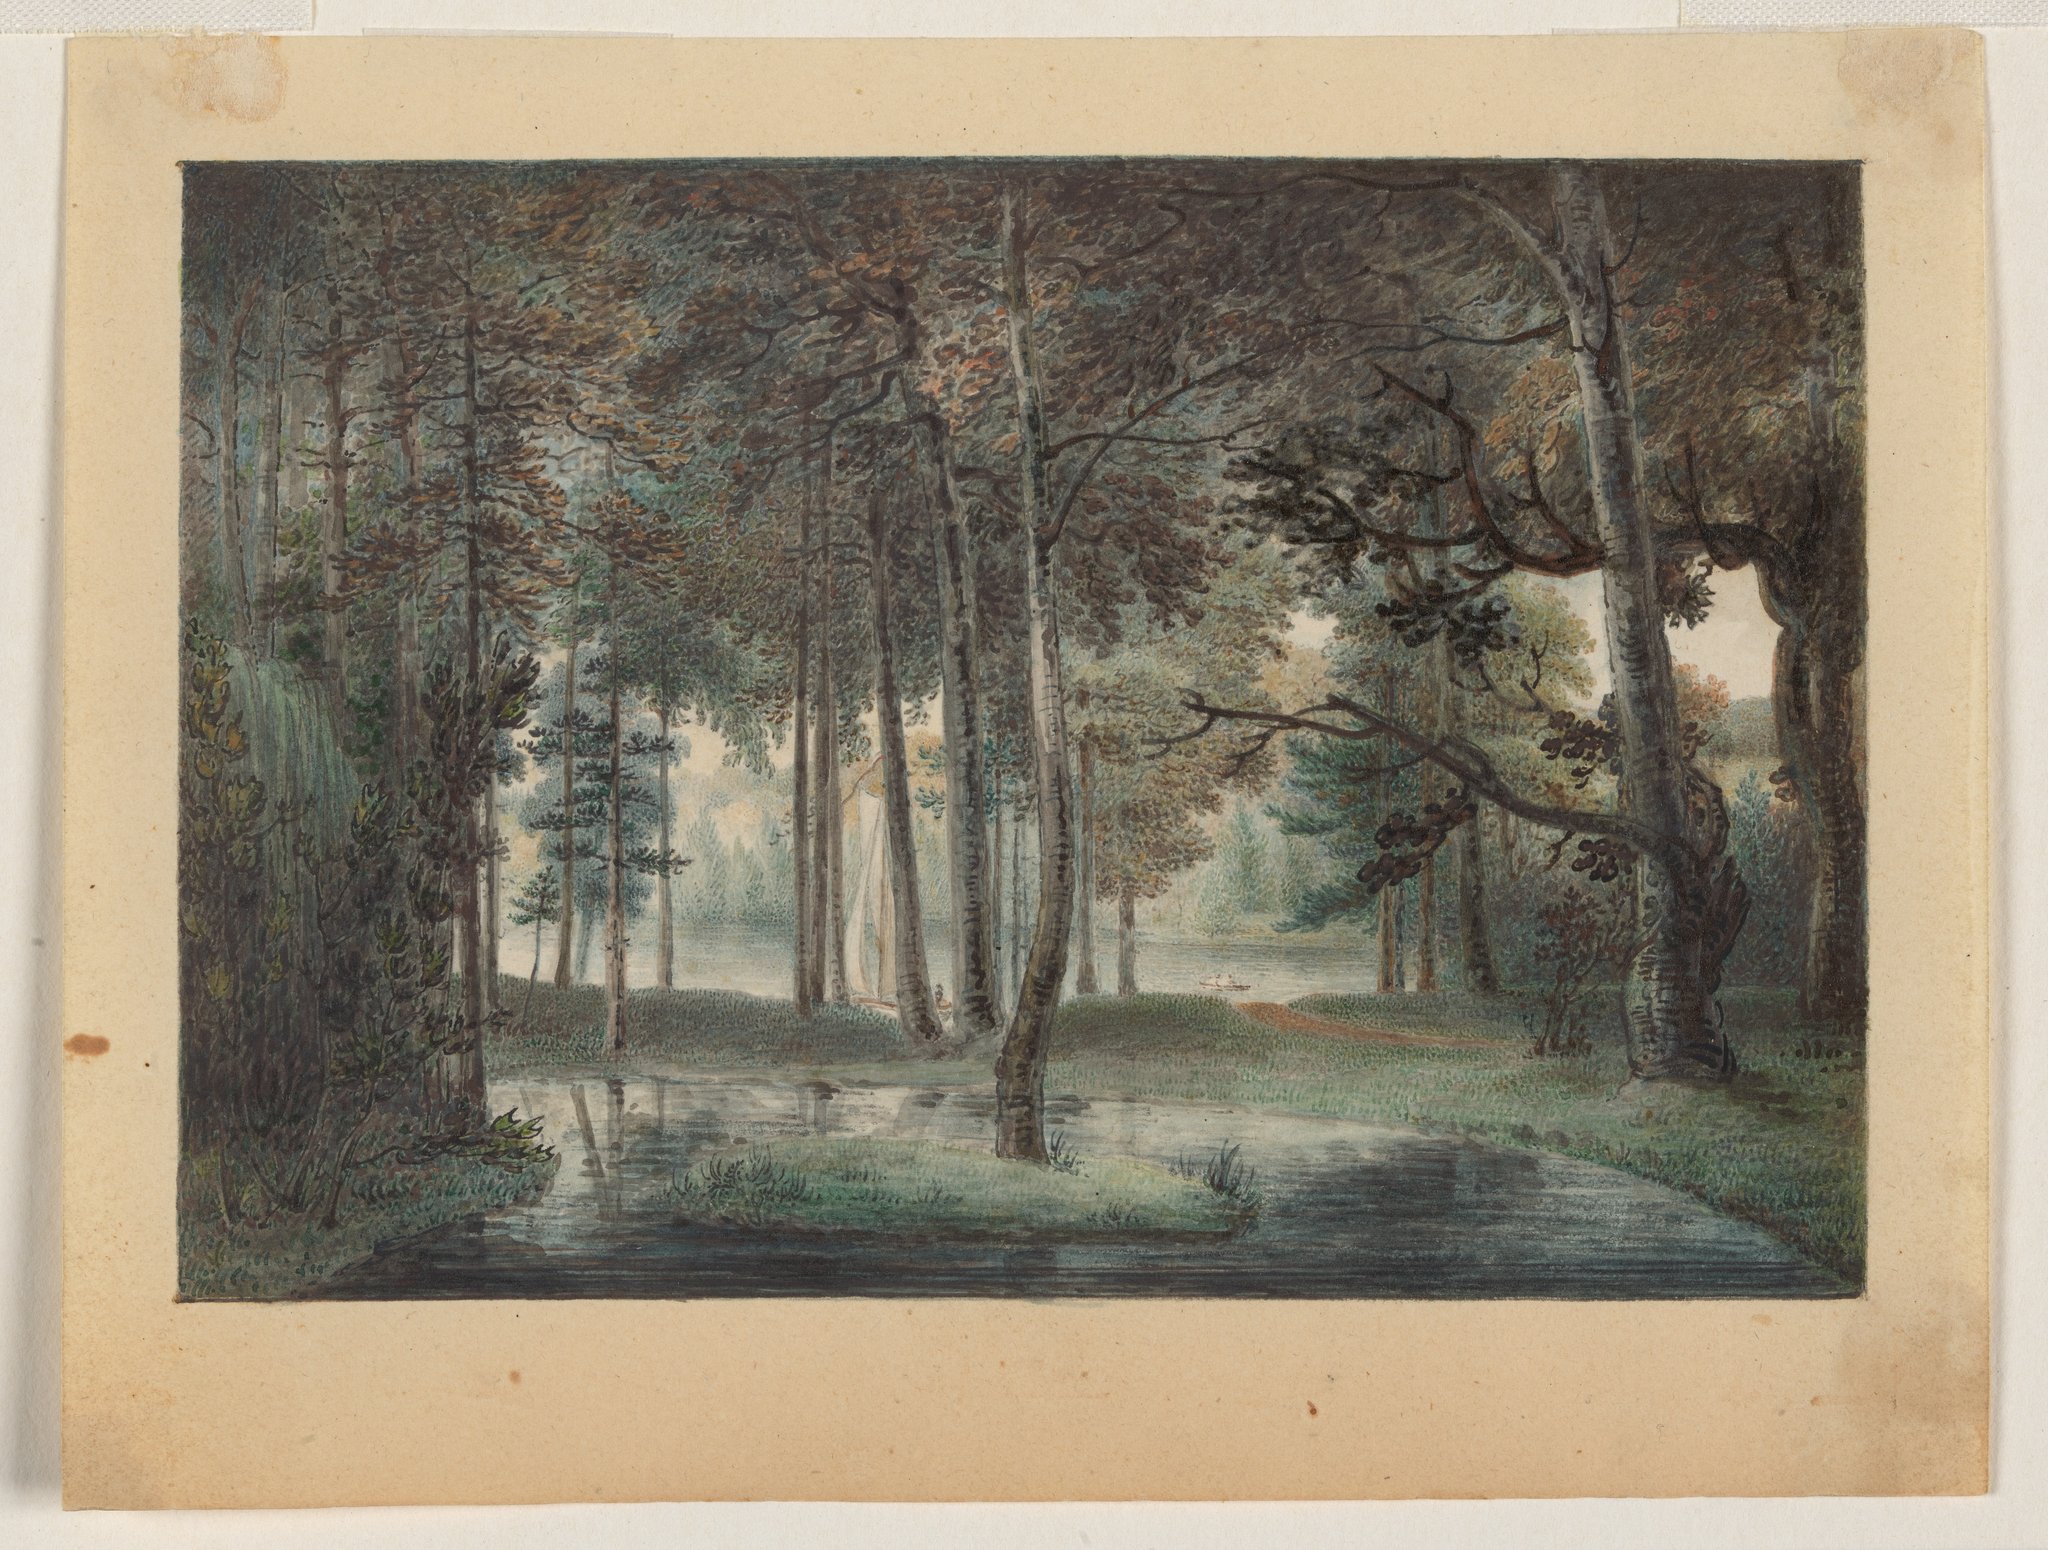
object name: drawing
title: A View from the Artist's Estate, Springland, or the Elysian Bower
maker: william russell birch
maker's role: artist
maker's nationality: american, born england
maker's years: 1755-1834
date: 1800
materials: graphite, ink, paper, watercolor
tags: trees